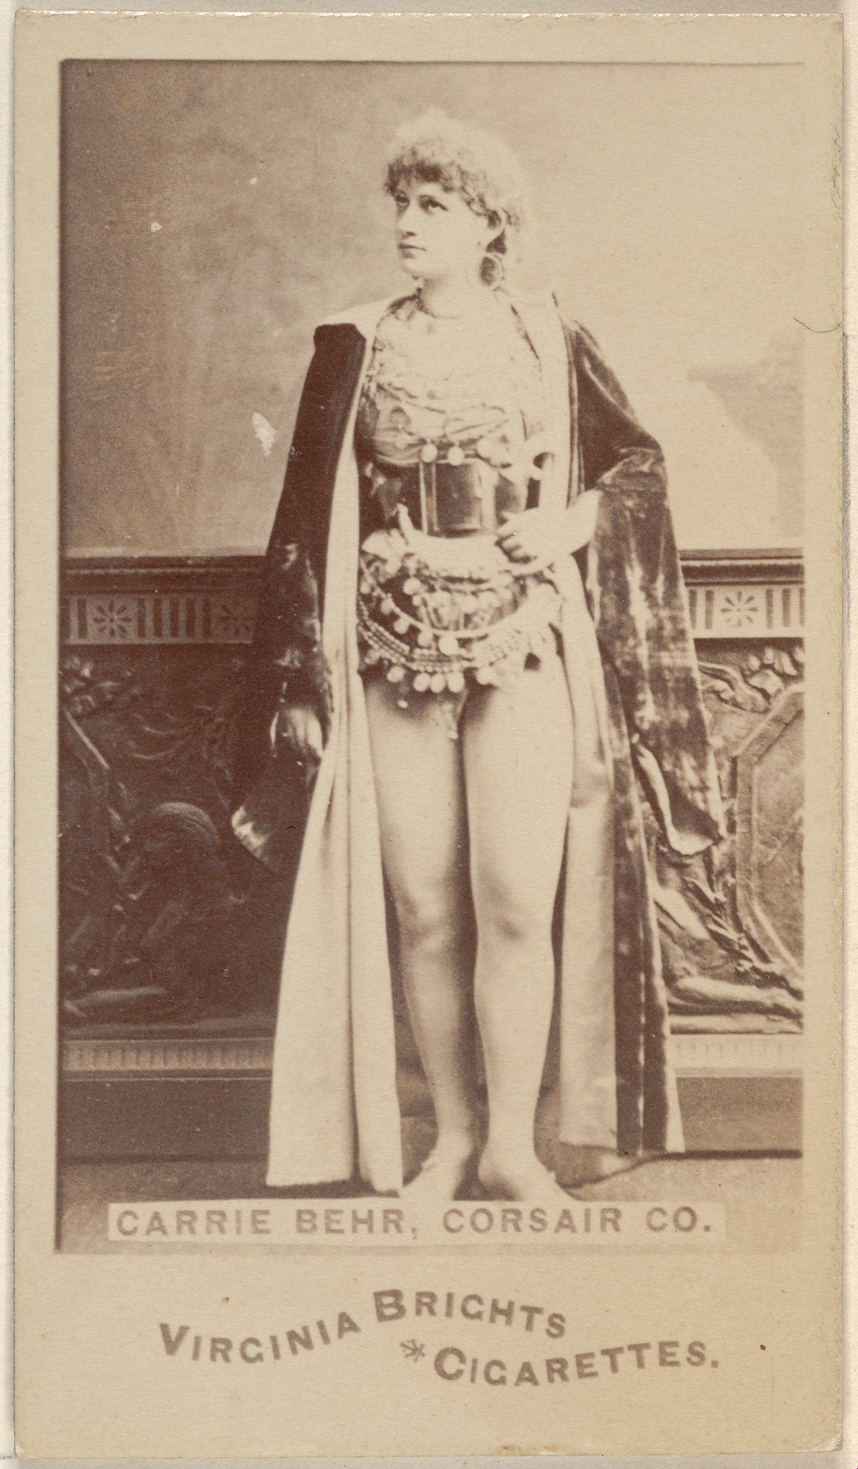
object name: photograph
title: Carrie Behr, Corsair Co., from the Actors and Actresses series (N45, Type 6) for Virginia Brights Cigarettes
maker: allen & ginter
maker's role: publisher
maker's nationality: american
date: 1888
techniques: albumen silver print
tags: portraits,women,actresses